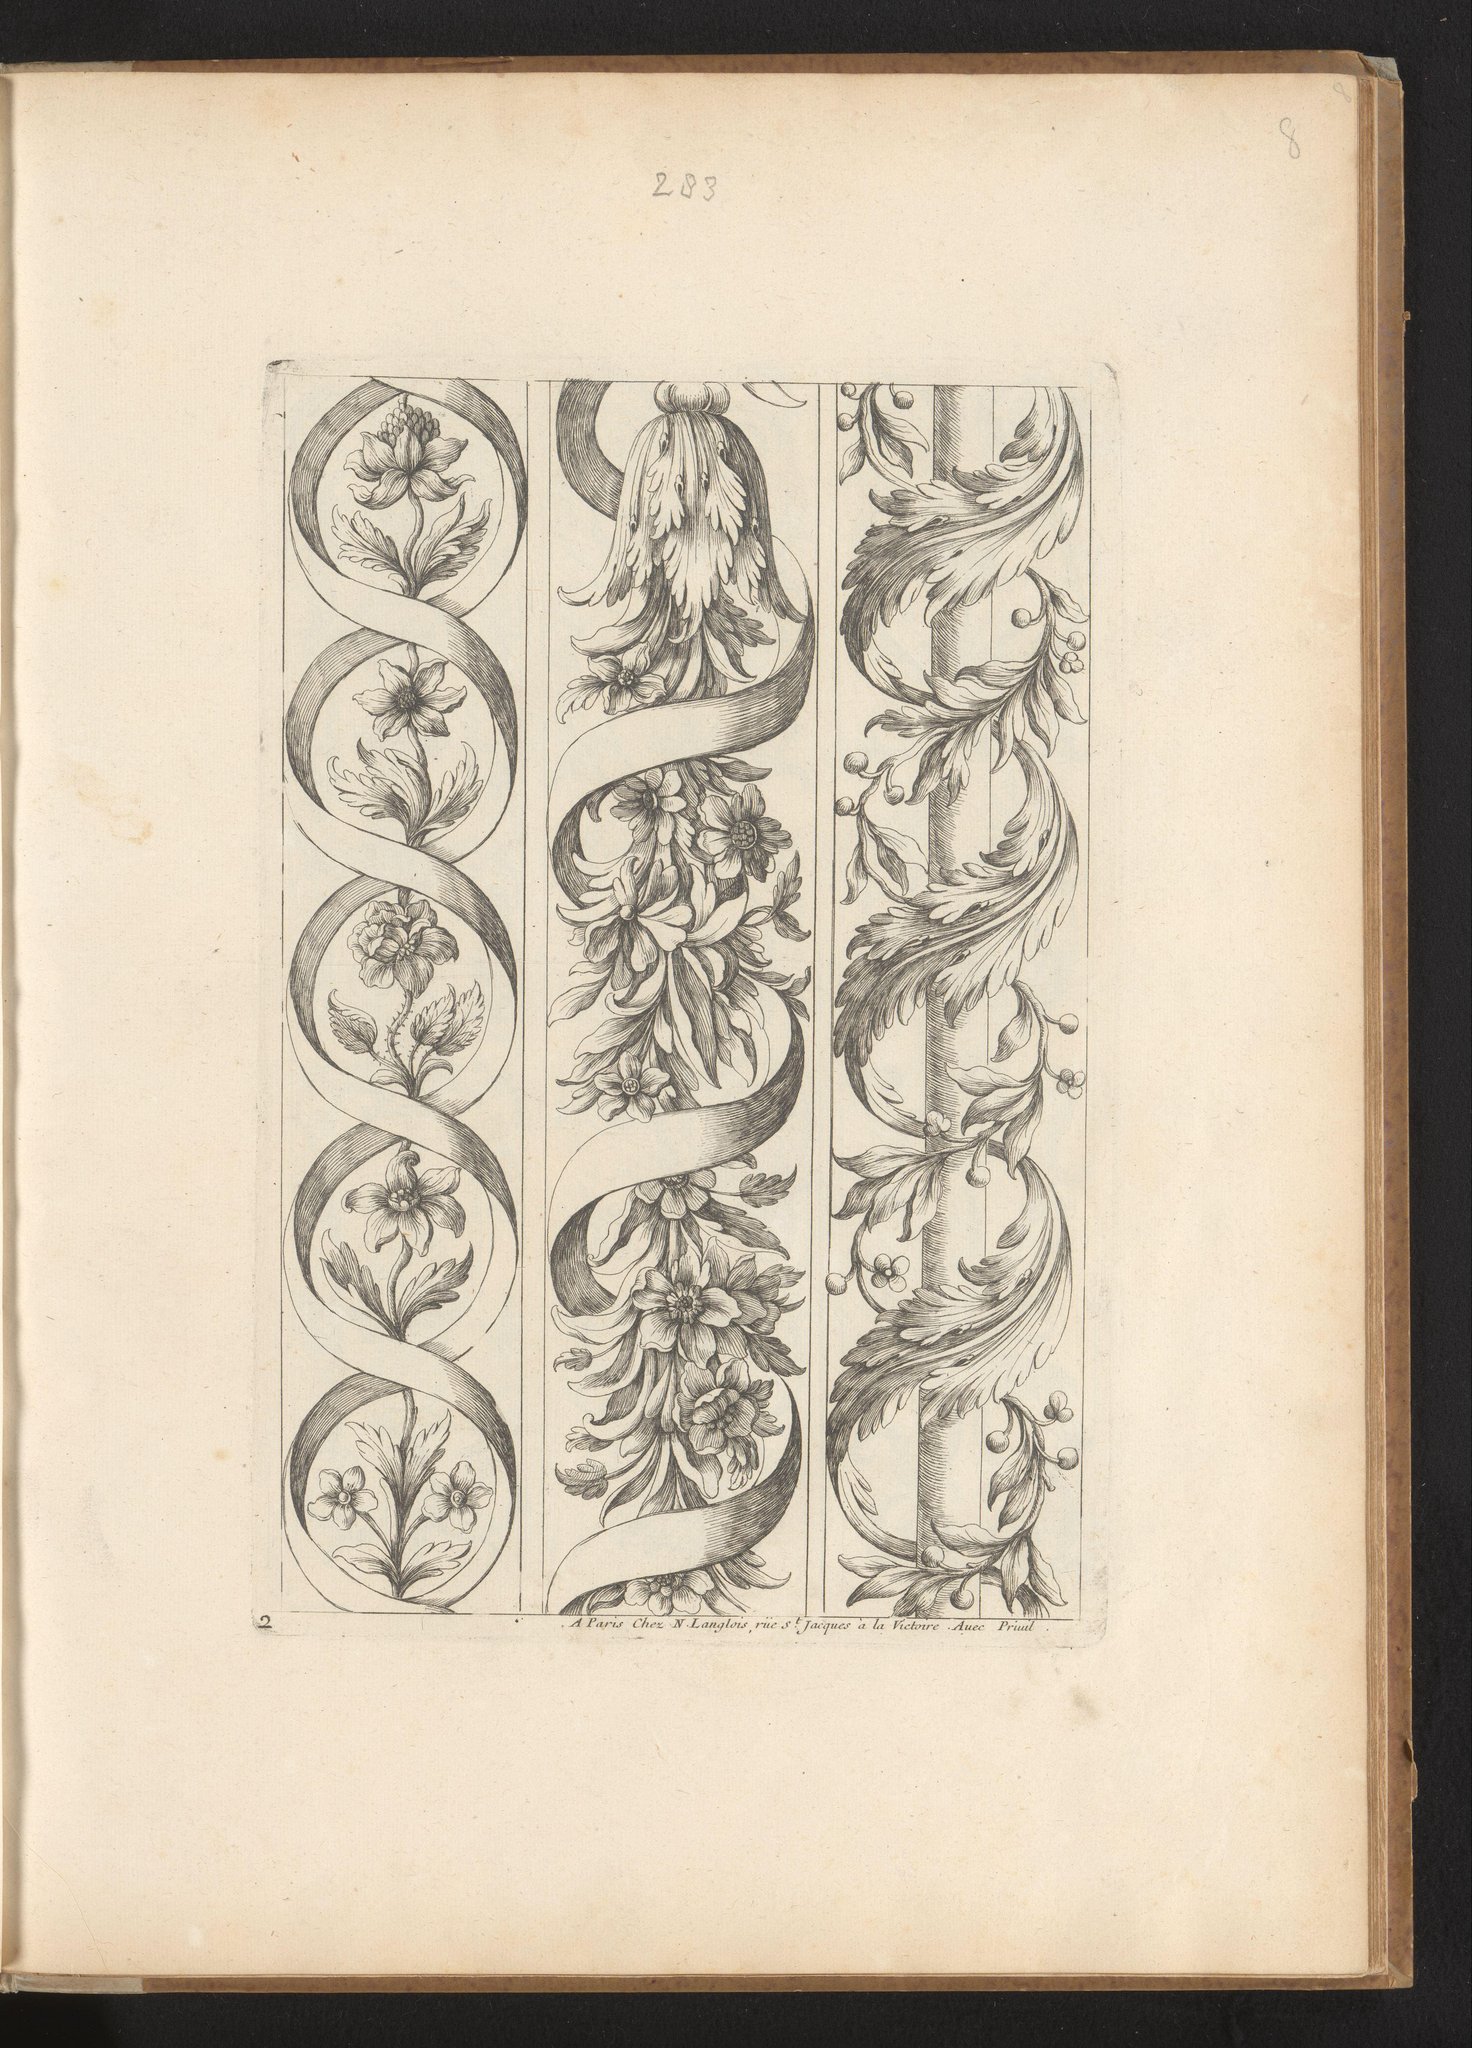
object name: album leaf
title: Ornamentpanelen met acanthusmotieven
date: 1650-1703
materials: paper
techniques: etching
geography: paris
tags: floral interlace ~ ornament, acanthus ~ ornament, ribbon, scroll, banderole ~ ornament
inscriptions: collector's mark: Lugt 2760, collector's mark: Lugt 2228a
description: Pilaarvormige ornamenten met linten en florale motieven. Deze prent maakt deel uit van een album.